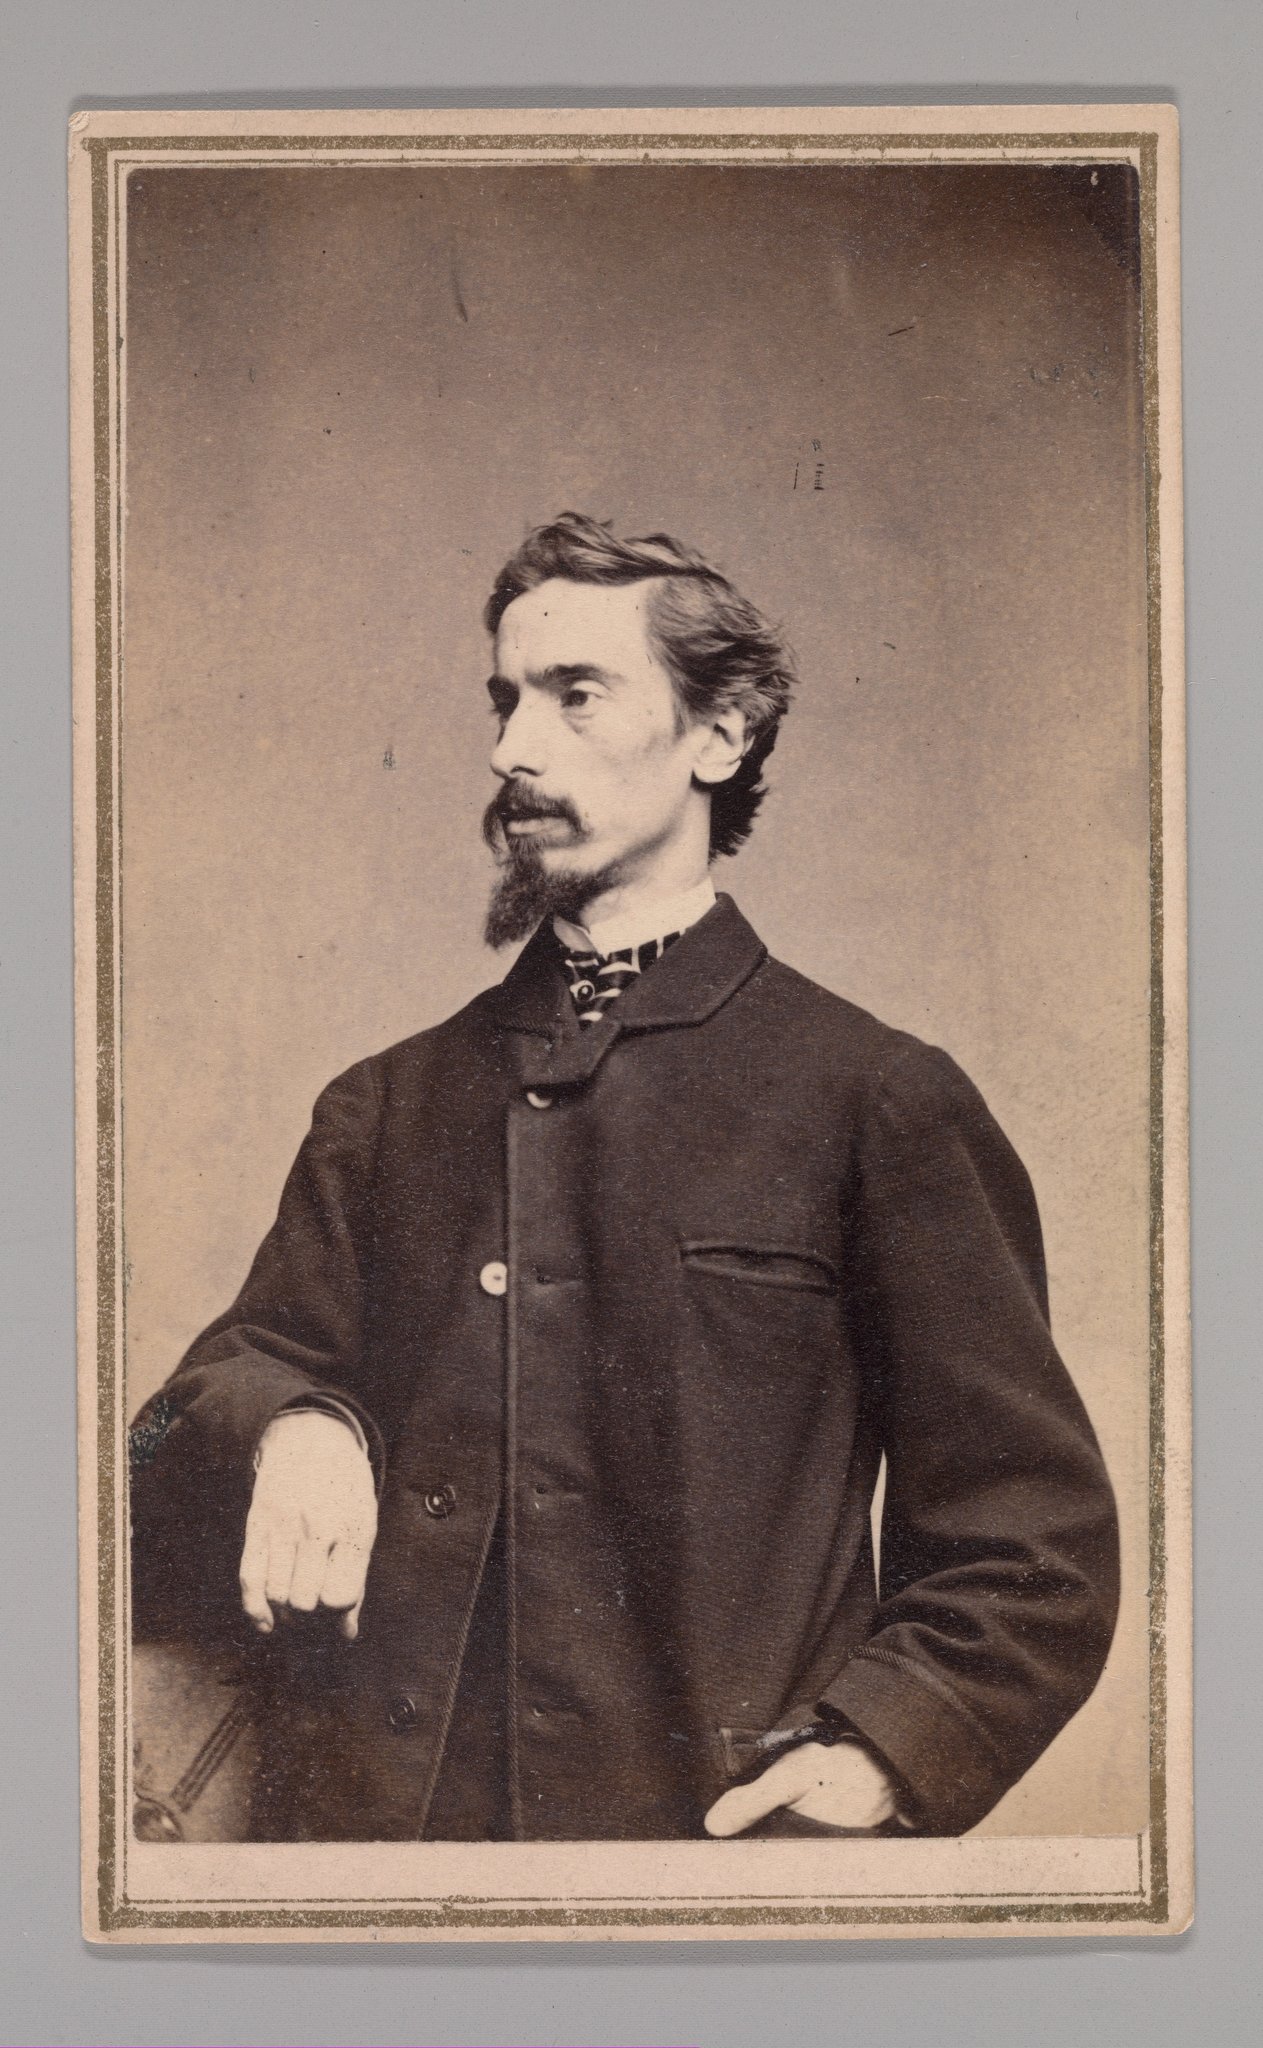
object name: carte de visite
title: [Laurent ?]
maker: george gardner rockwood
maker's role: fotograaf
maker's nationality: american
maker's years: 1832-1911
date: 1860-1869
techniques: albumen silver print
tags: men,portraits